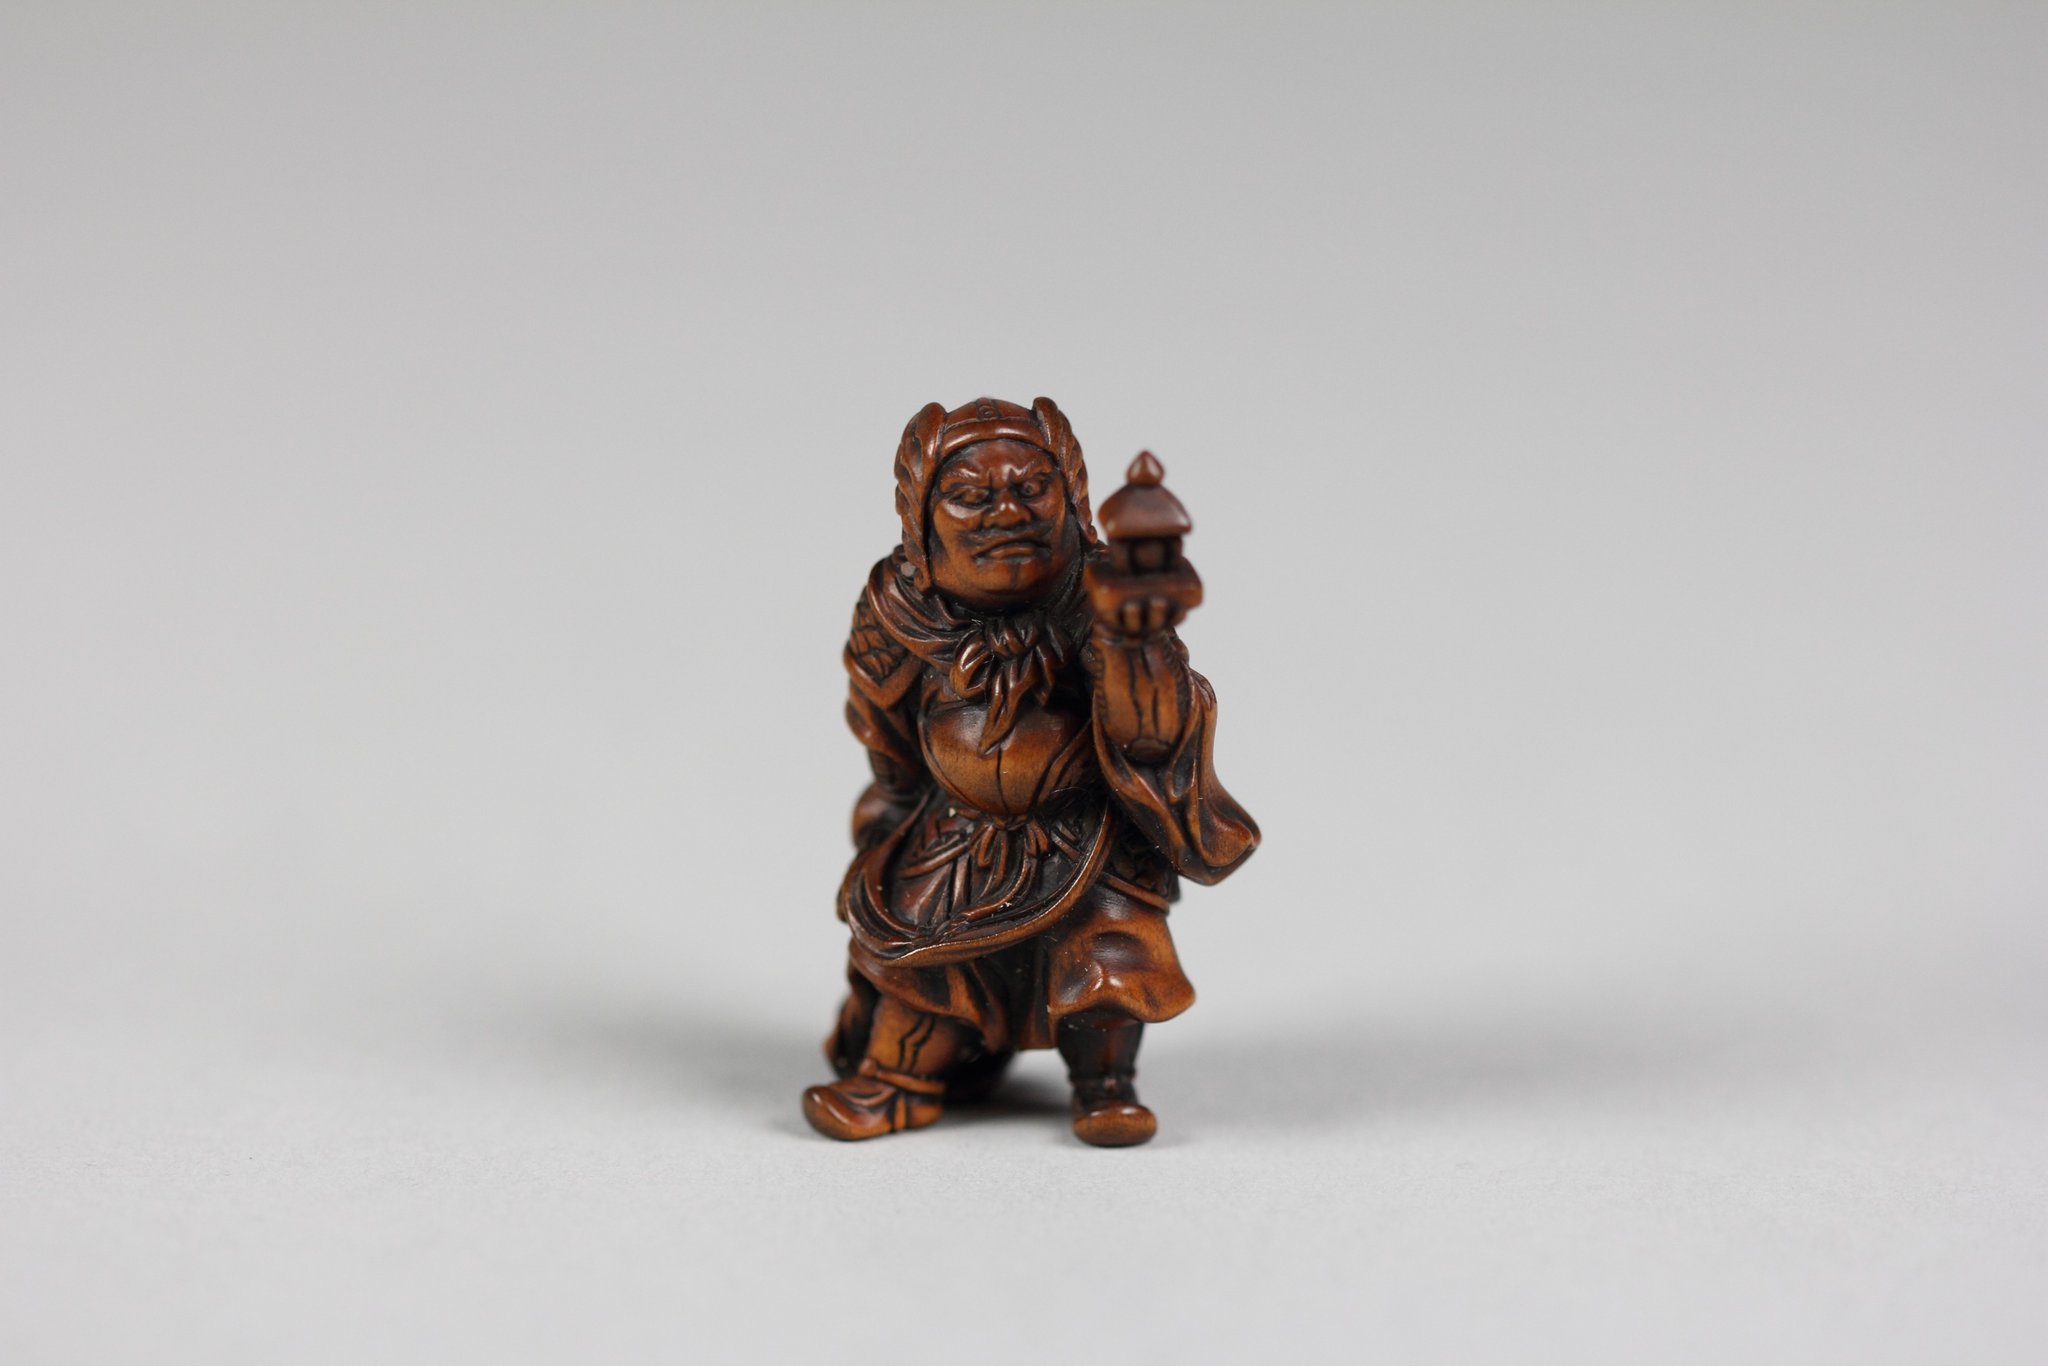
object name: netsuke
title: Netsuke of Bishamon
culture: japanese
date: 1801-1900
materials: wood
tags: men